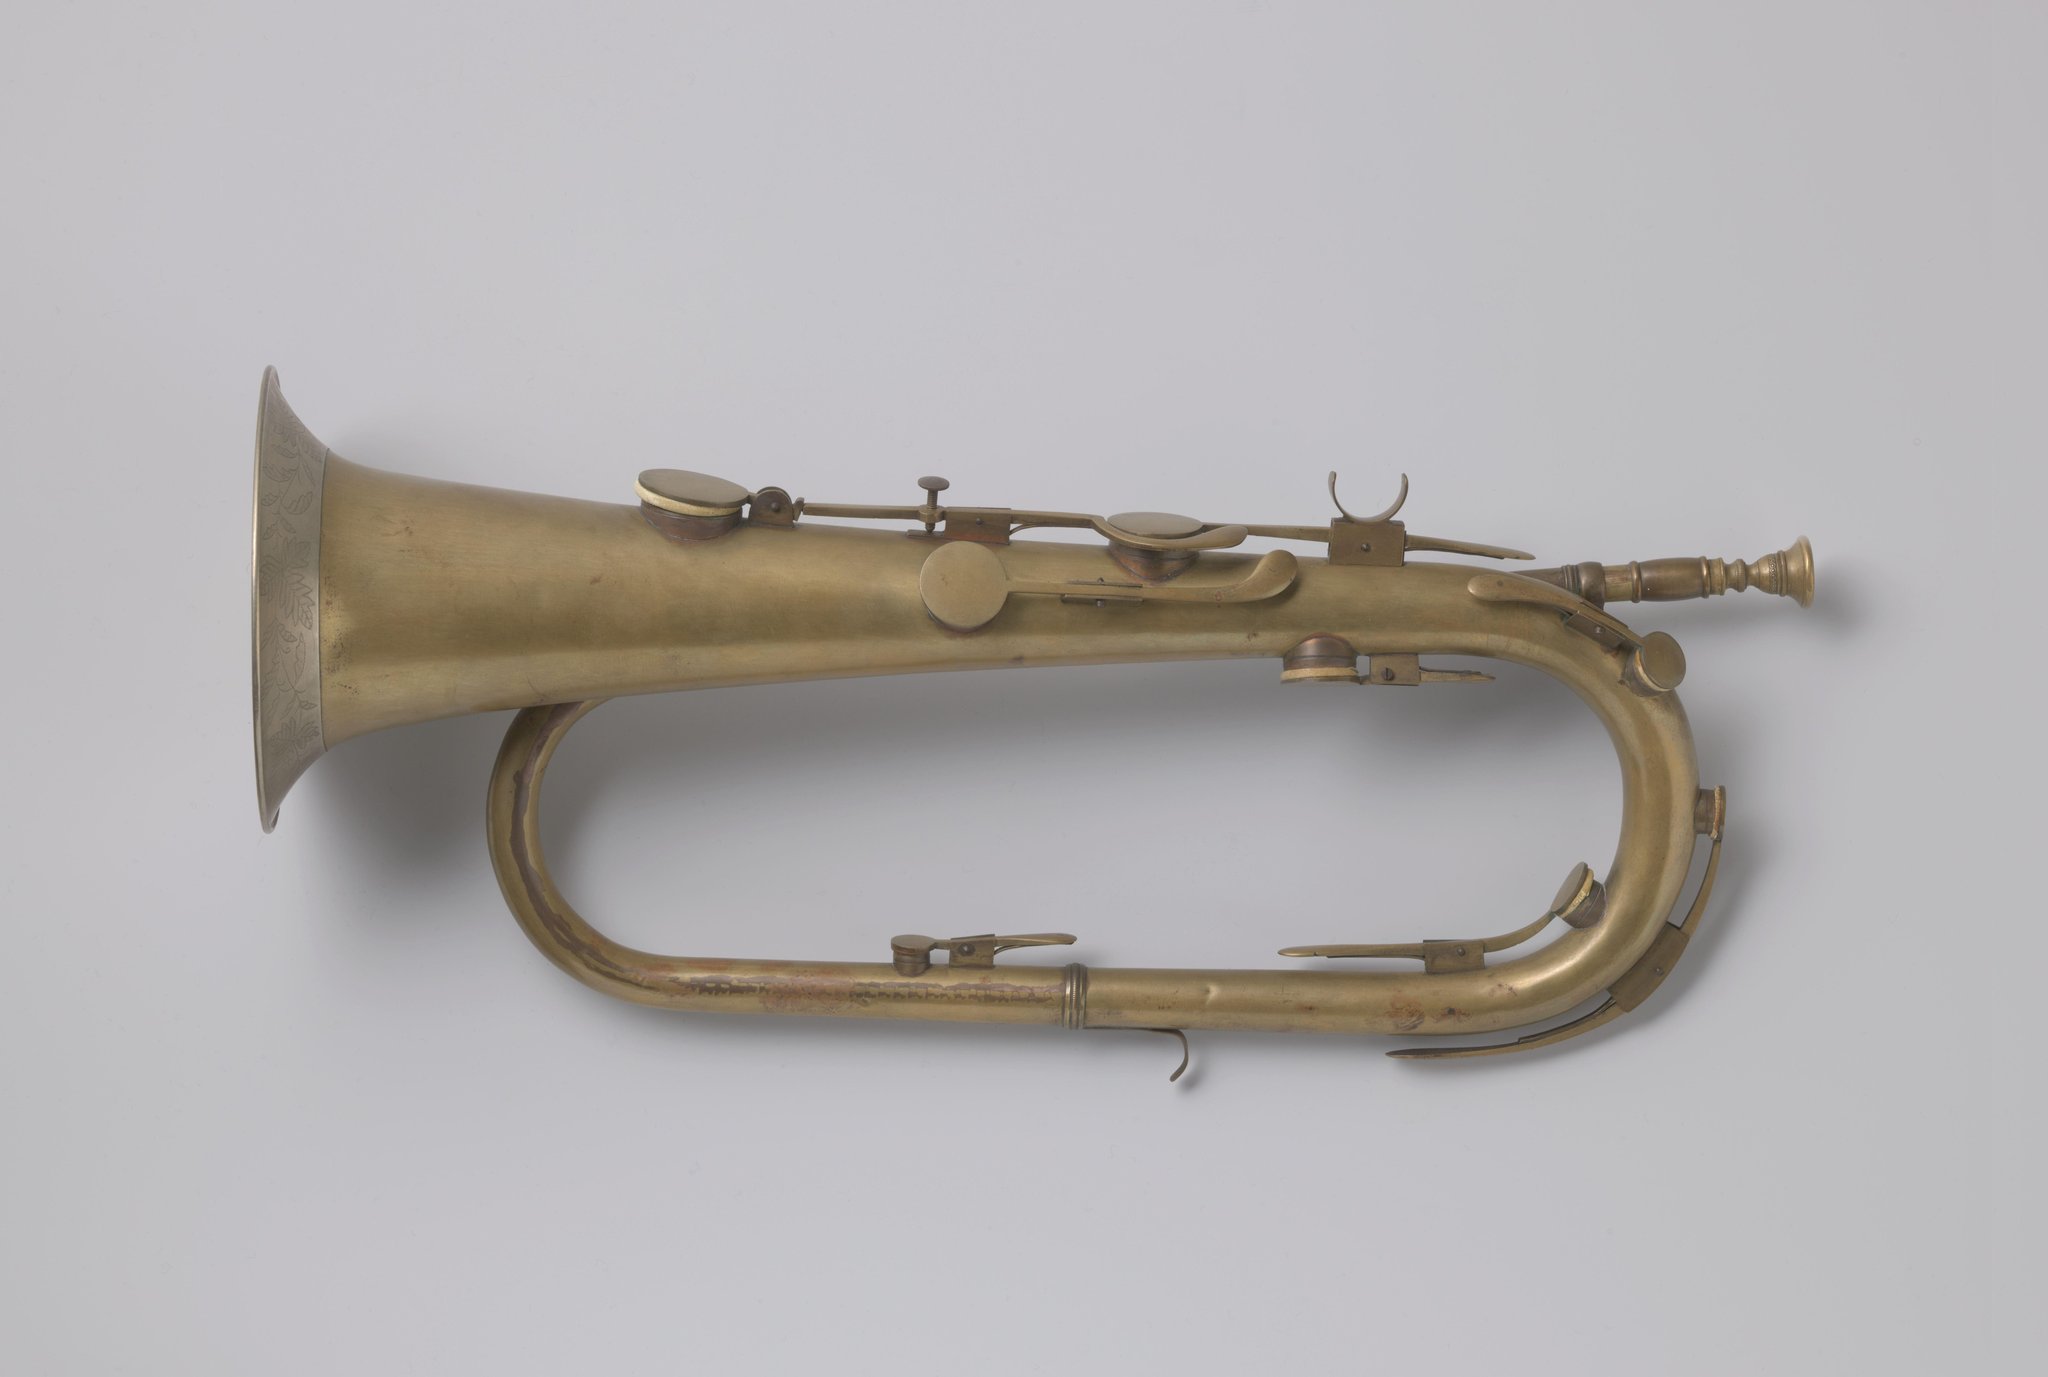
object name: keyed bugle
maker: Anonymous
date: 1850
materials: copper, alloy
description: Kleppenbugel in Bes met acht kleppen, waarvan de onderste open. De platte, ronde kleppen zijn gemonteerd in zadels en sluiten op kokers rondom de gaten. Klep en toets uit een stuk. Met steunzadel voor de middelvinger van de rechterhand. De toets van de derde klep loopt hieronder door. Eveneens steunhaak voor de pink van de linkerhand. Rondom de beker is een krans gelegd van nieuwzilver, warin bladornamenten zijn gegraveerd.